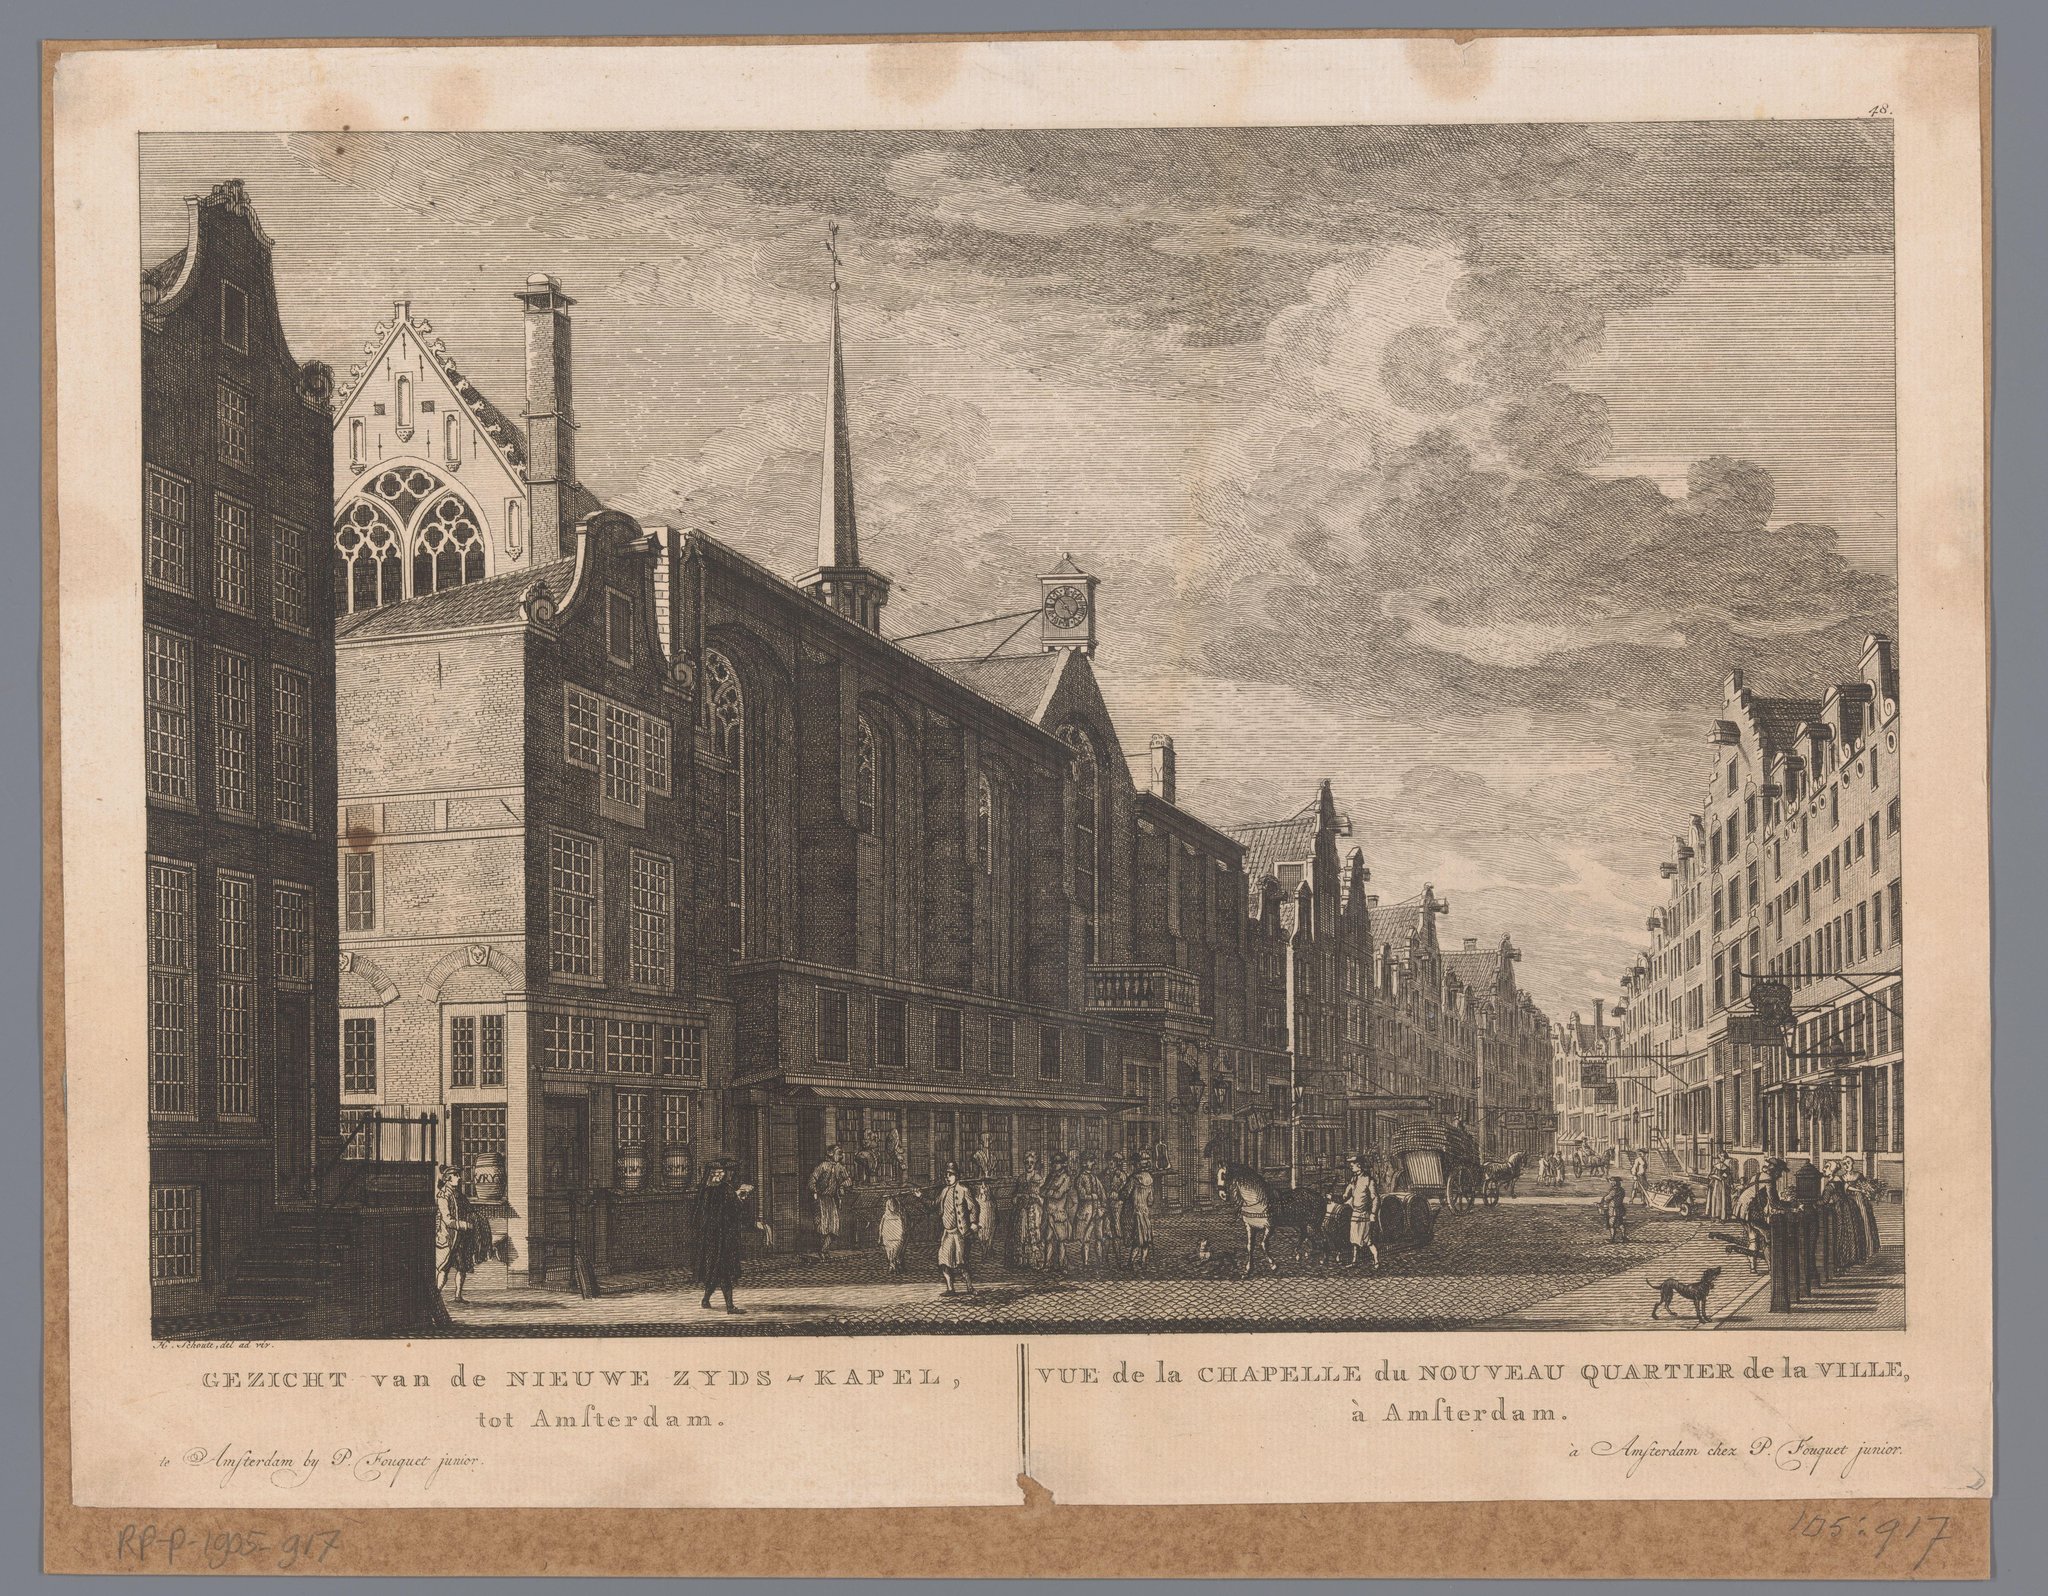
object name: print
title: Gezicht op de Nieuwezijds Kapel te Amsterdam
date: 1770-1783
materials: paper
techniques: etching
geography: amsterdam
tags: church (exterior) - qq - small church, chapel, street (+ city(-scape) with figures, staffage)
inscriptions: collector's mark: Lugt 2228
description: Vanaf 1760 gaf Pierre Fouquet stadsgezichten van Amsterdam naar tekeningen van verschillende kunstenaars uit. Deze prenten werden aanvankelijk los verkocht. Later werden ze samengebonden verkocht in verschillende volgordes en aantallen in: (1). Afbeeldingen van de wyd-vermaarde koopstad Amsterdam benevens des zelvs voornaamste gebouwen en gezigten alle naar het leeven getekend / Receuil des edifices les plus considerables et des plus belles vues, de la fameuse ville d'Amsterdam, dessinées d'après nature. Amsterdam: Pierre Fouquet, 1778-1783. (2). Nieuwe atlas, van de voornaamste gebouwen en gezigten der stad Amsterdam, met derzelver beknopte beschryvingen. 2 dln. Amsterdam: Daniël Jean Changuion en Petrus den Hengst [in opdracht van Pierre Fouquet], 1783. (3). Stijl, Simon. Amsterdam, in zyne geschiedenissen, voorregten, koophandel, gebouwen, kerkenstaat, schoolen, schutterye, gilden en regeeringe, beschreeven. Om te dienen ten vervolge op het werk van Jan Wagenaar (…). 10 dln. Amsterdam en Harlingen: Petrus Conradi en Folkert van der Plaats, 1788-1801. (4). Nieuwe atlas, van de voornaamste gebouwen en gezigten der stad Amsterdam. Met derzelver beknopte beschryvingen. Amsterdam: Evert Maaskamp, 1805. De prent in deze staat is gebruikt in (1) of (2).